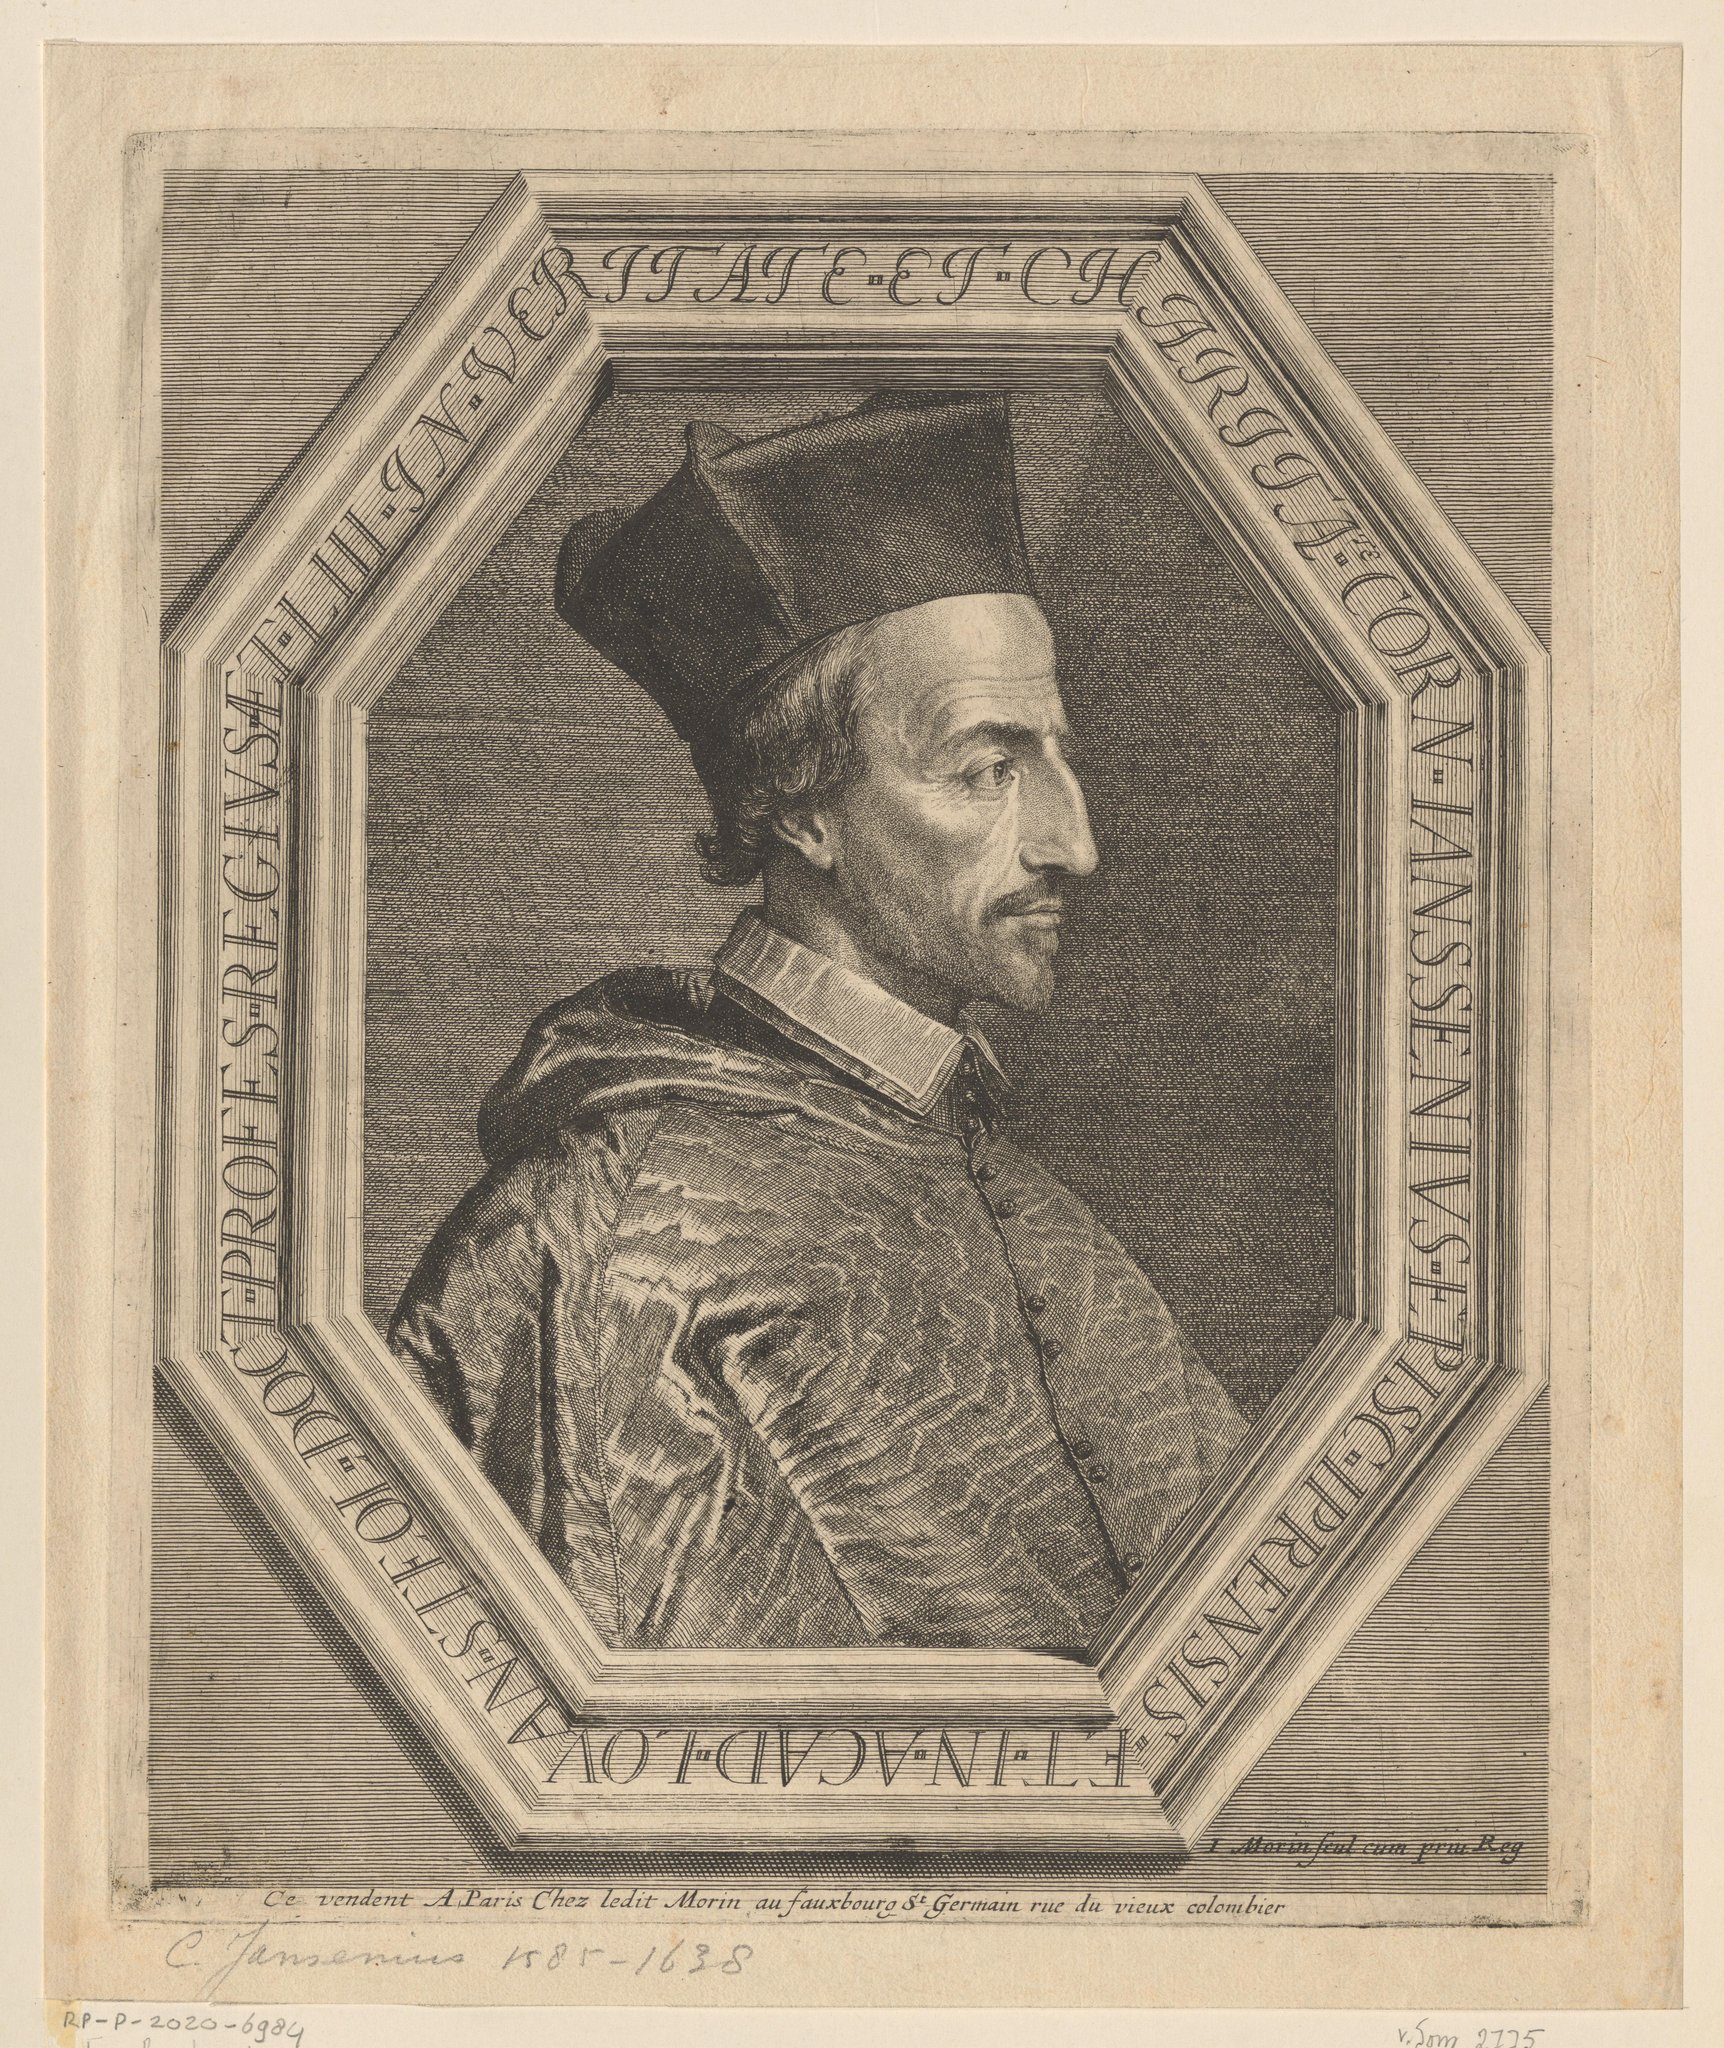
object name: print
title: Portret van Cornelius Jansenius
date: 1638-1650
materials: paper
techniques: engraving, etching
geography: paris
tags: cornelius jansenius, archbishop, bishop, etc. (roman catholic), theologian, historical persons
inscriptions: collector's mark: Lugt 964